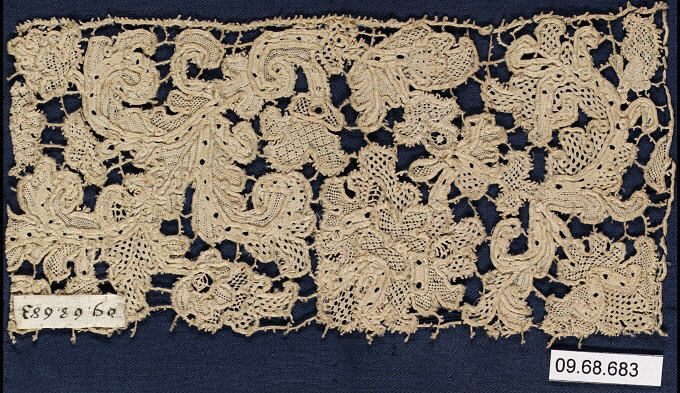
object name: fragment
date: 1601-1700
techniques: lace